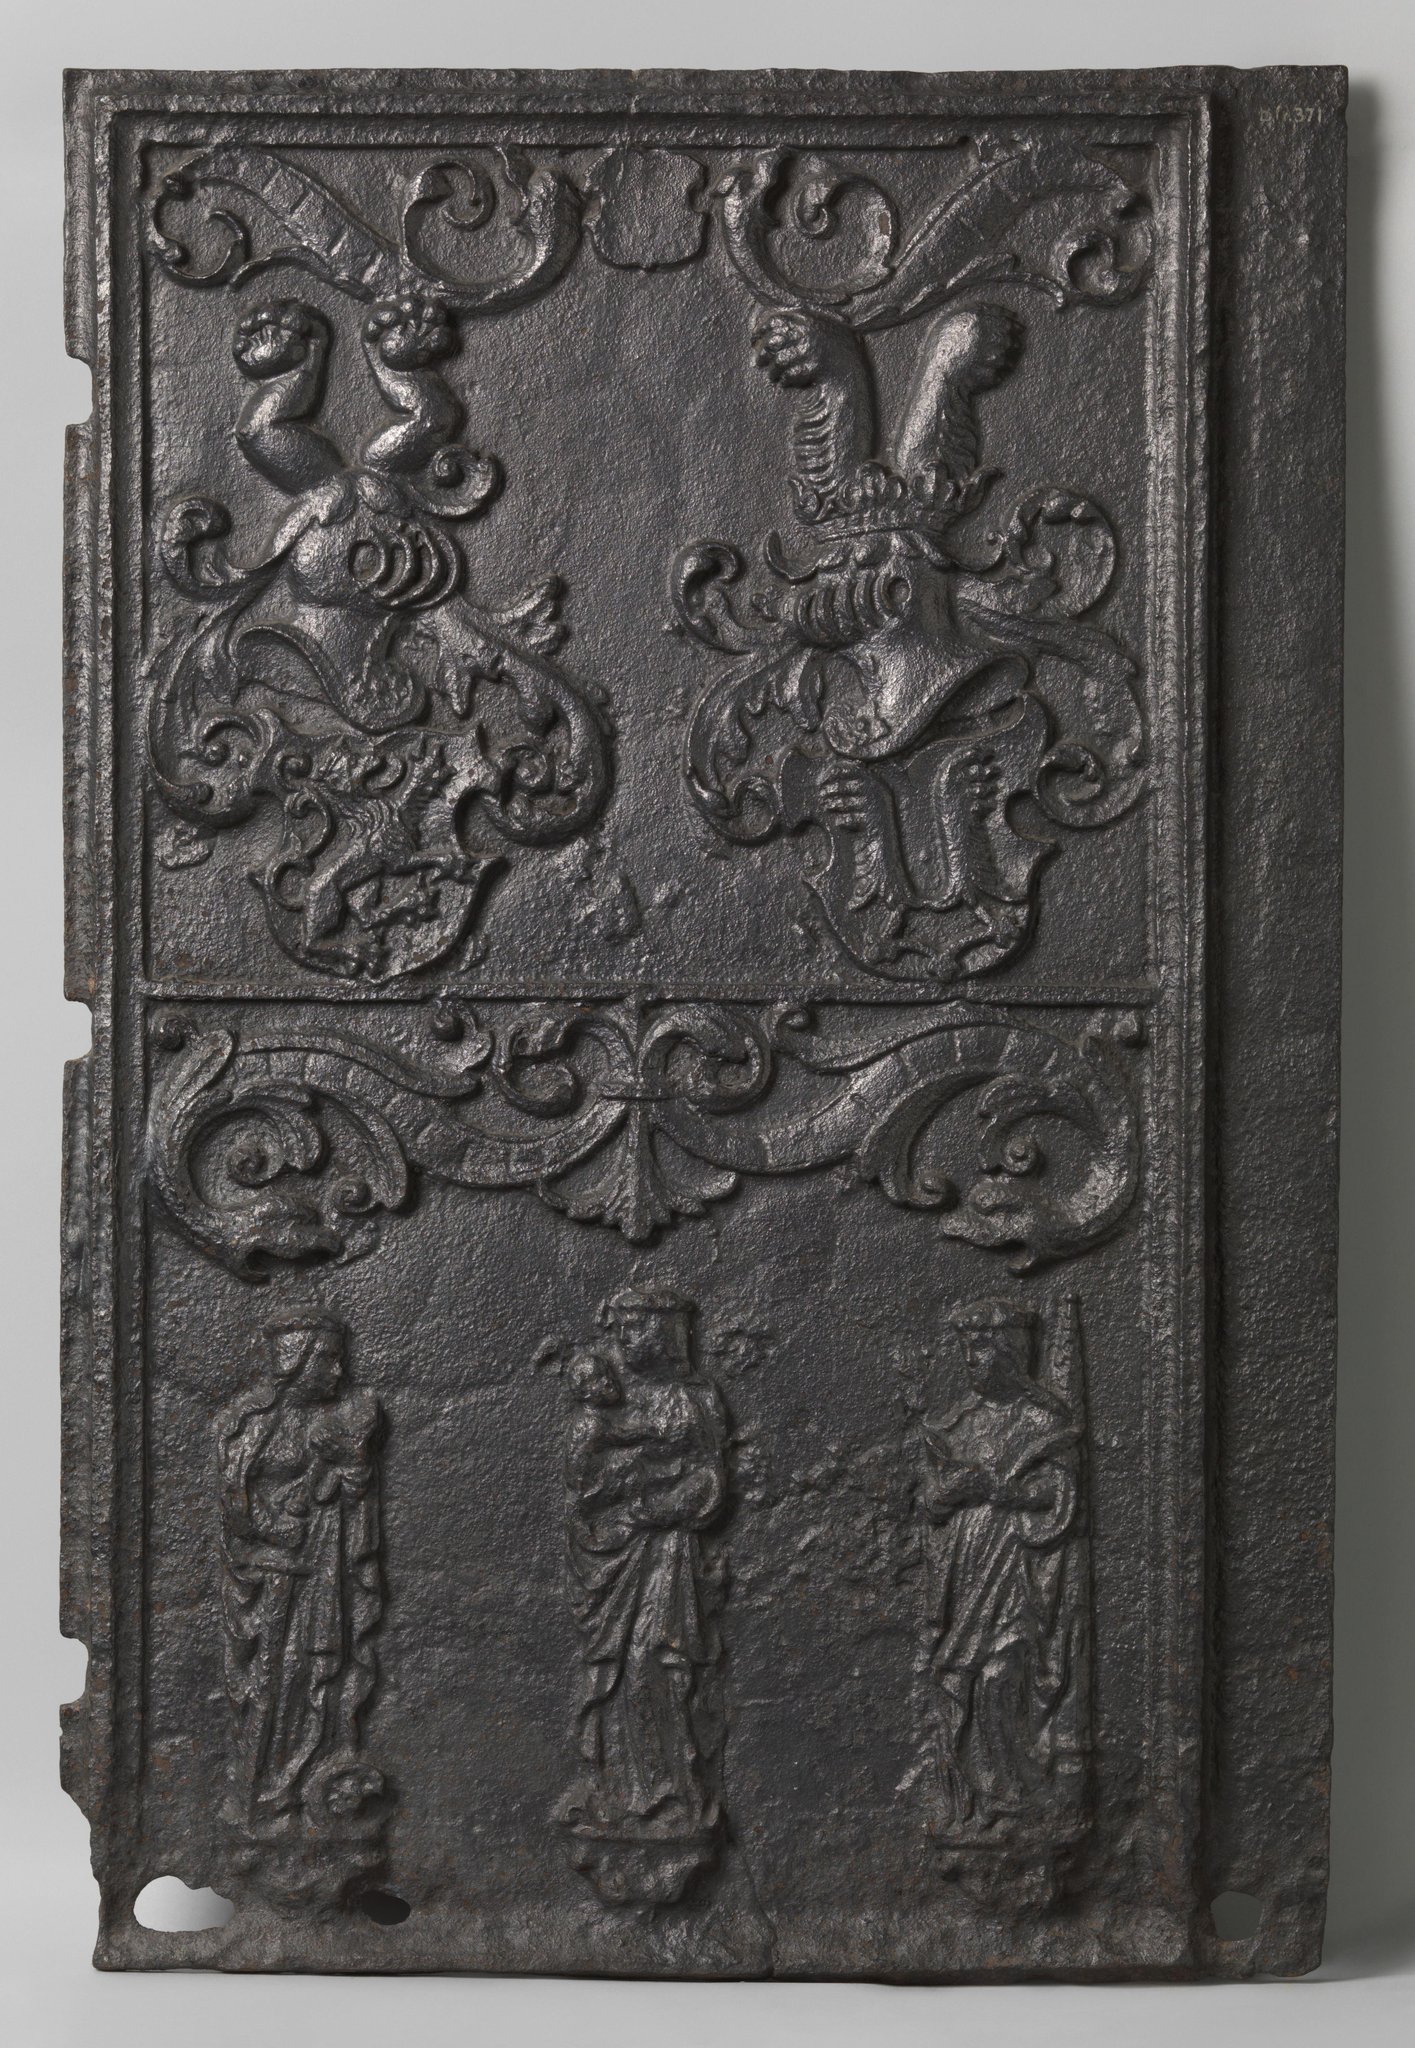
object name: stove plate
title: Kachelplaat met de wapenschilden van Joost, graaf van Bronckhorst, heer van Borculo en Maria, gravin van Hoya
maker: Anonymous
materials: iron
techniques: casting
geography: germany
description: Kachelplaat van gietijzer, verdeeld in twee zones. In de bovenste zone zijn twee wapenschilden. Links die van Joost, graaf van Bronckhorst, heer van Borculo (1503-1553). Rechts het familiewapen van Maria van Hoya, gravin van Bronckhorst, vrouwe van Borculo (1508-1579). In de onderste zone drie vrouwelijke heiligen op een console. Links Catharina, in het midden Maria met kind en rechts Barbara. Daarboven een symmetrisch ornament van bladeren. Het geheel is omlijst met een dubbel geprofileerde rand.